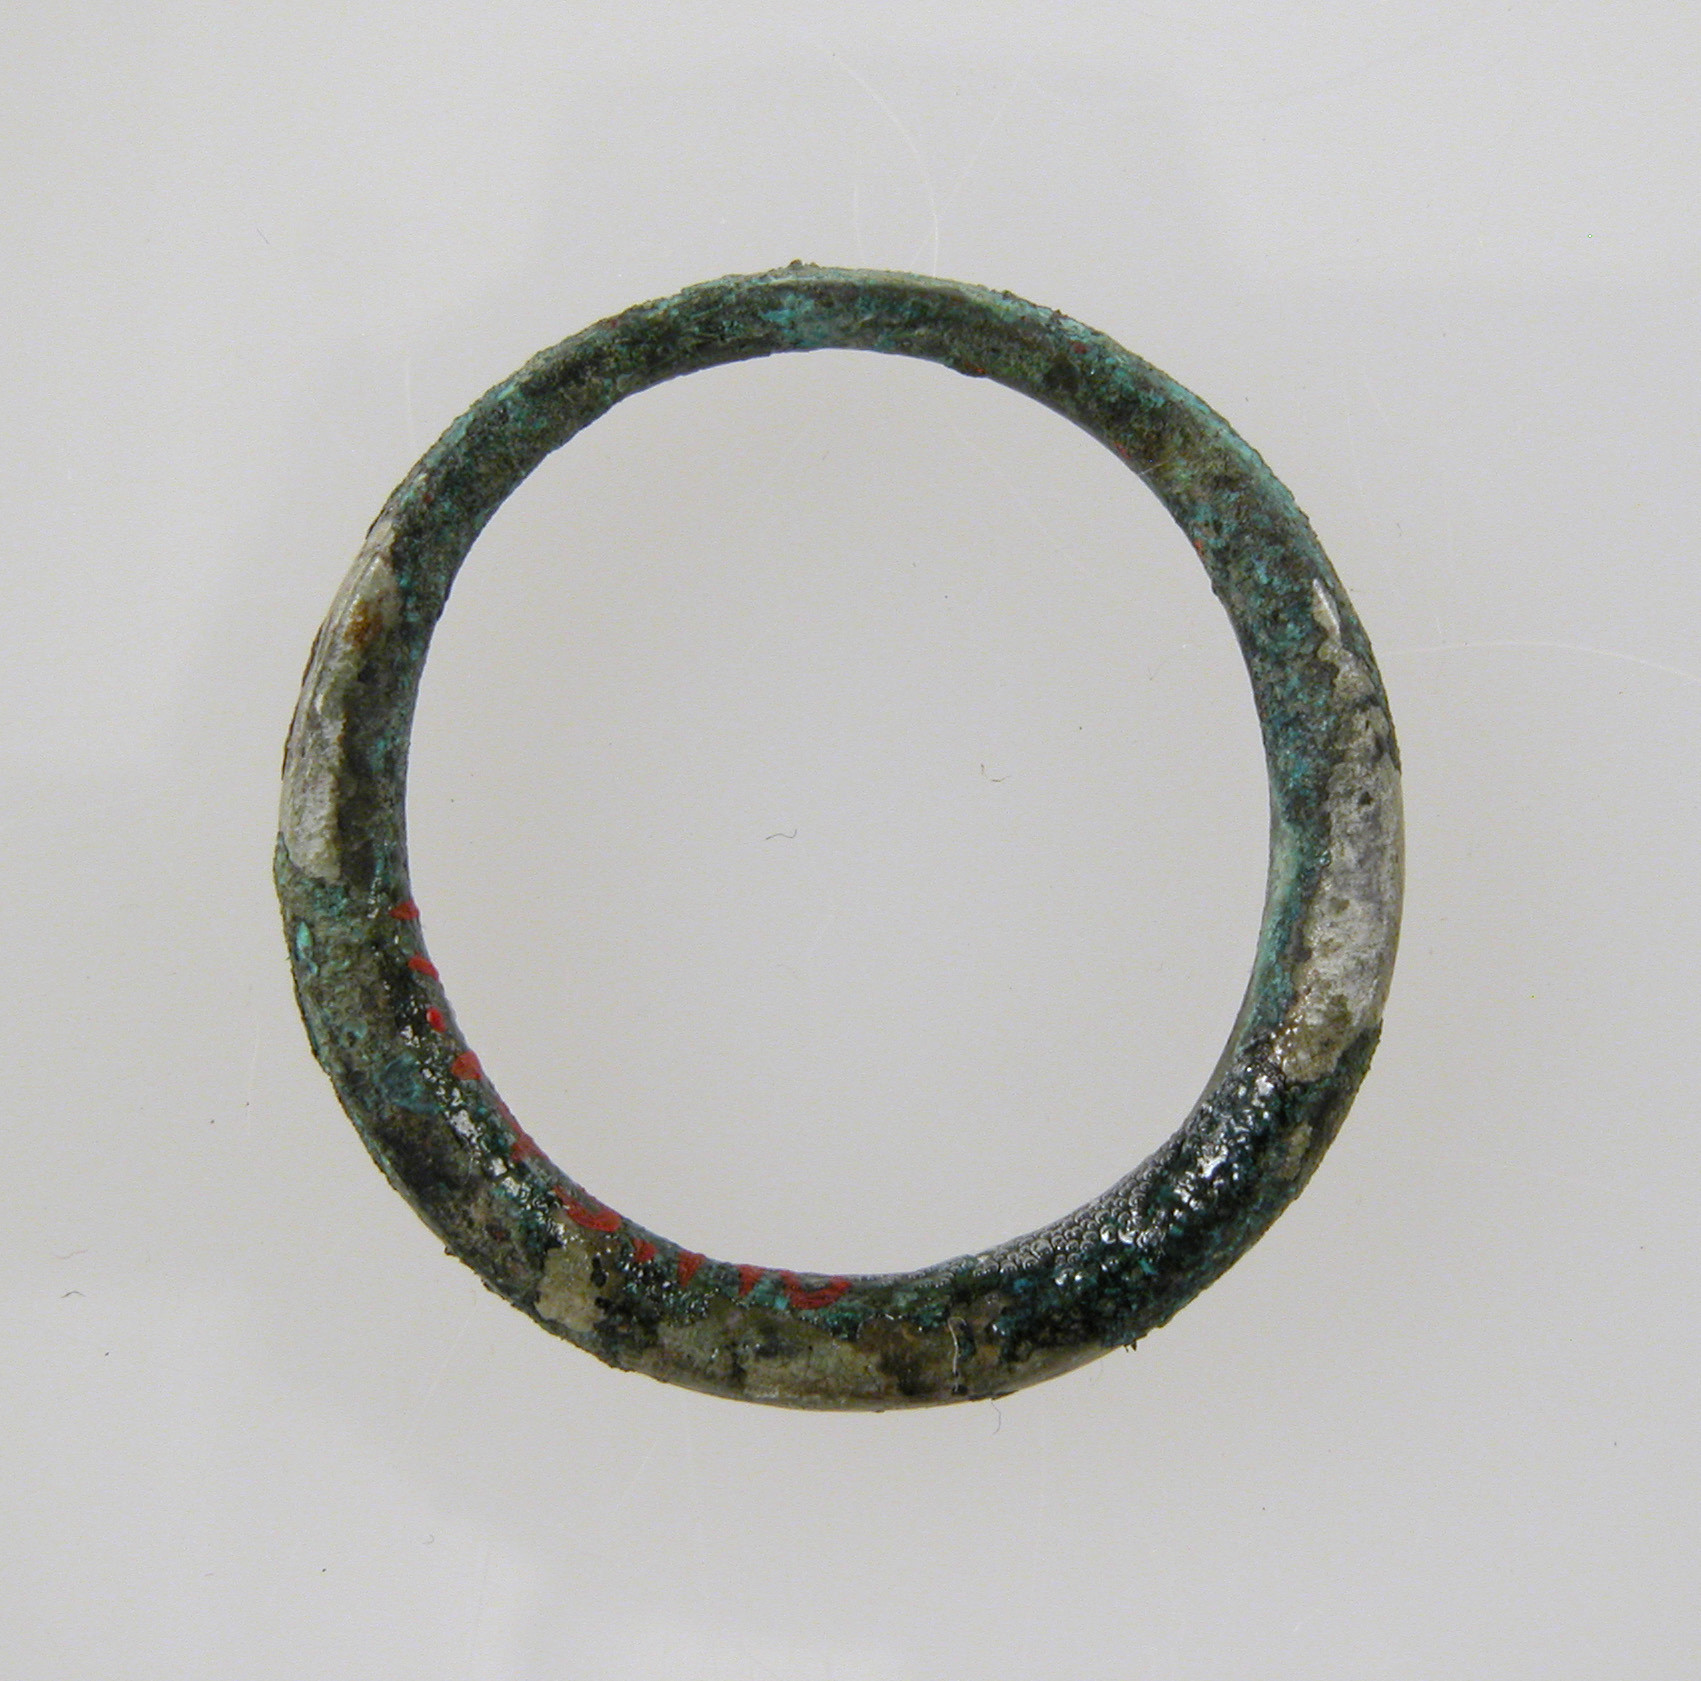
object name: ring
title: Plain Ring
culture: frankish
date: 601-700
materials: copper alloy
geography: germany